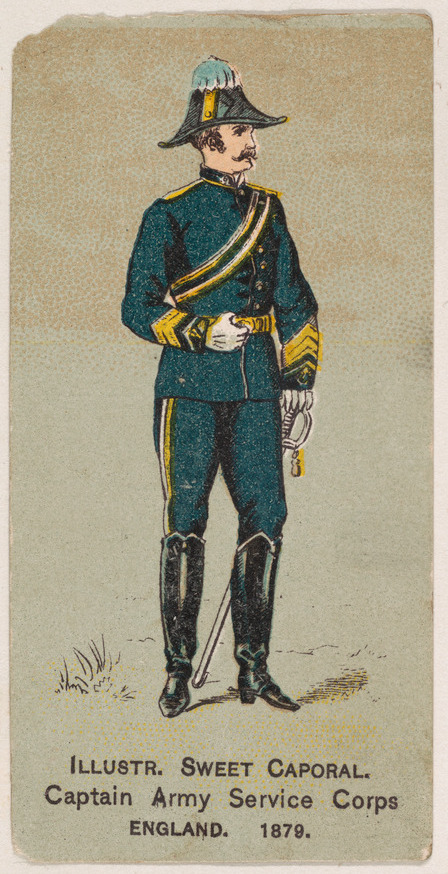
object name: print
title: Captain Army Service Corps, England, 1879, from the Military Series (N224) issued by Kinney Tobacco Company to promote Sweet Caporal Cigarettes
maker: kinney brothers tobacco company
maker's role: publisher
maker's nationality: american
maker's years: 1869-2011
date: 1888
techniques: color lithograph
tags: army,men,profiles